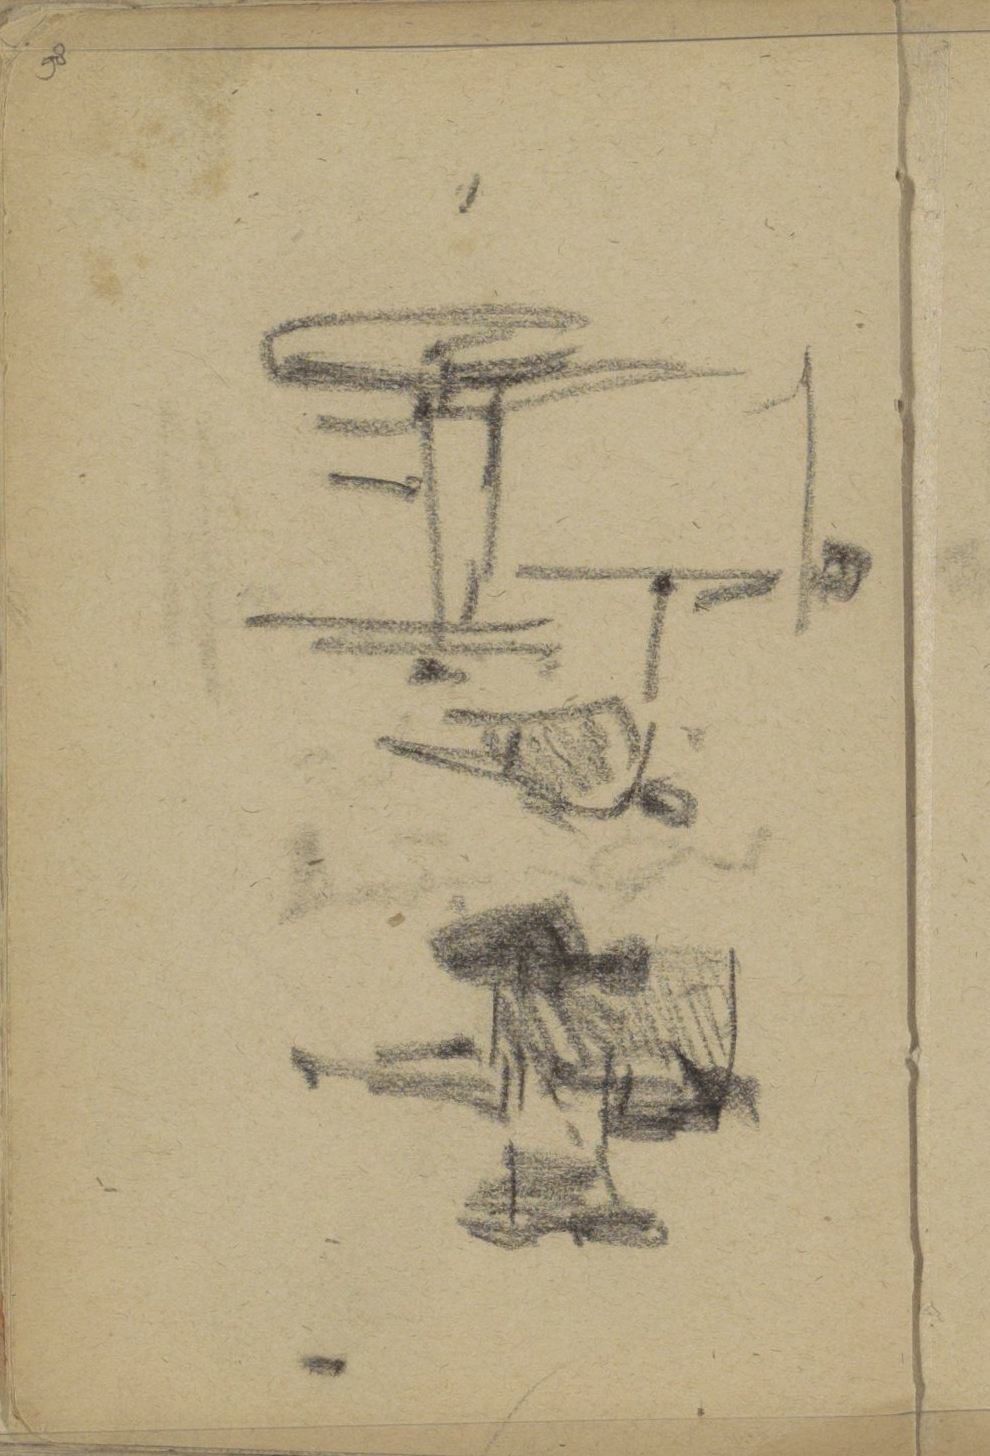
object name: sketchbook leaf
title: Paardenkar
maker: george hendrik breitner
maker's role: draughtsman, painter, print maker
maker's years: 1857-1923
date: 1881-1883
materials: chalk, paper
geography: south holland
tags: horse, (farm) wagon, freight wagon, cart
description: Paardenkar. Pagina 98 uit een schetsboek met 70 bladen.